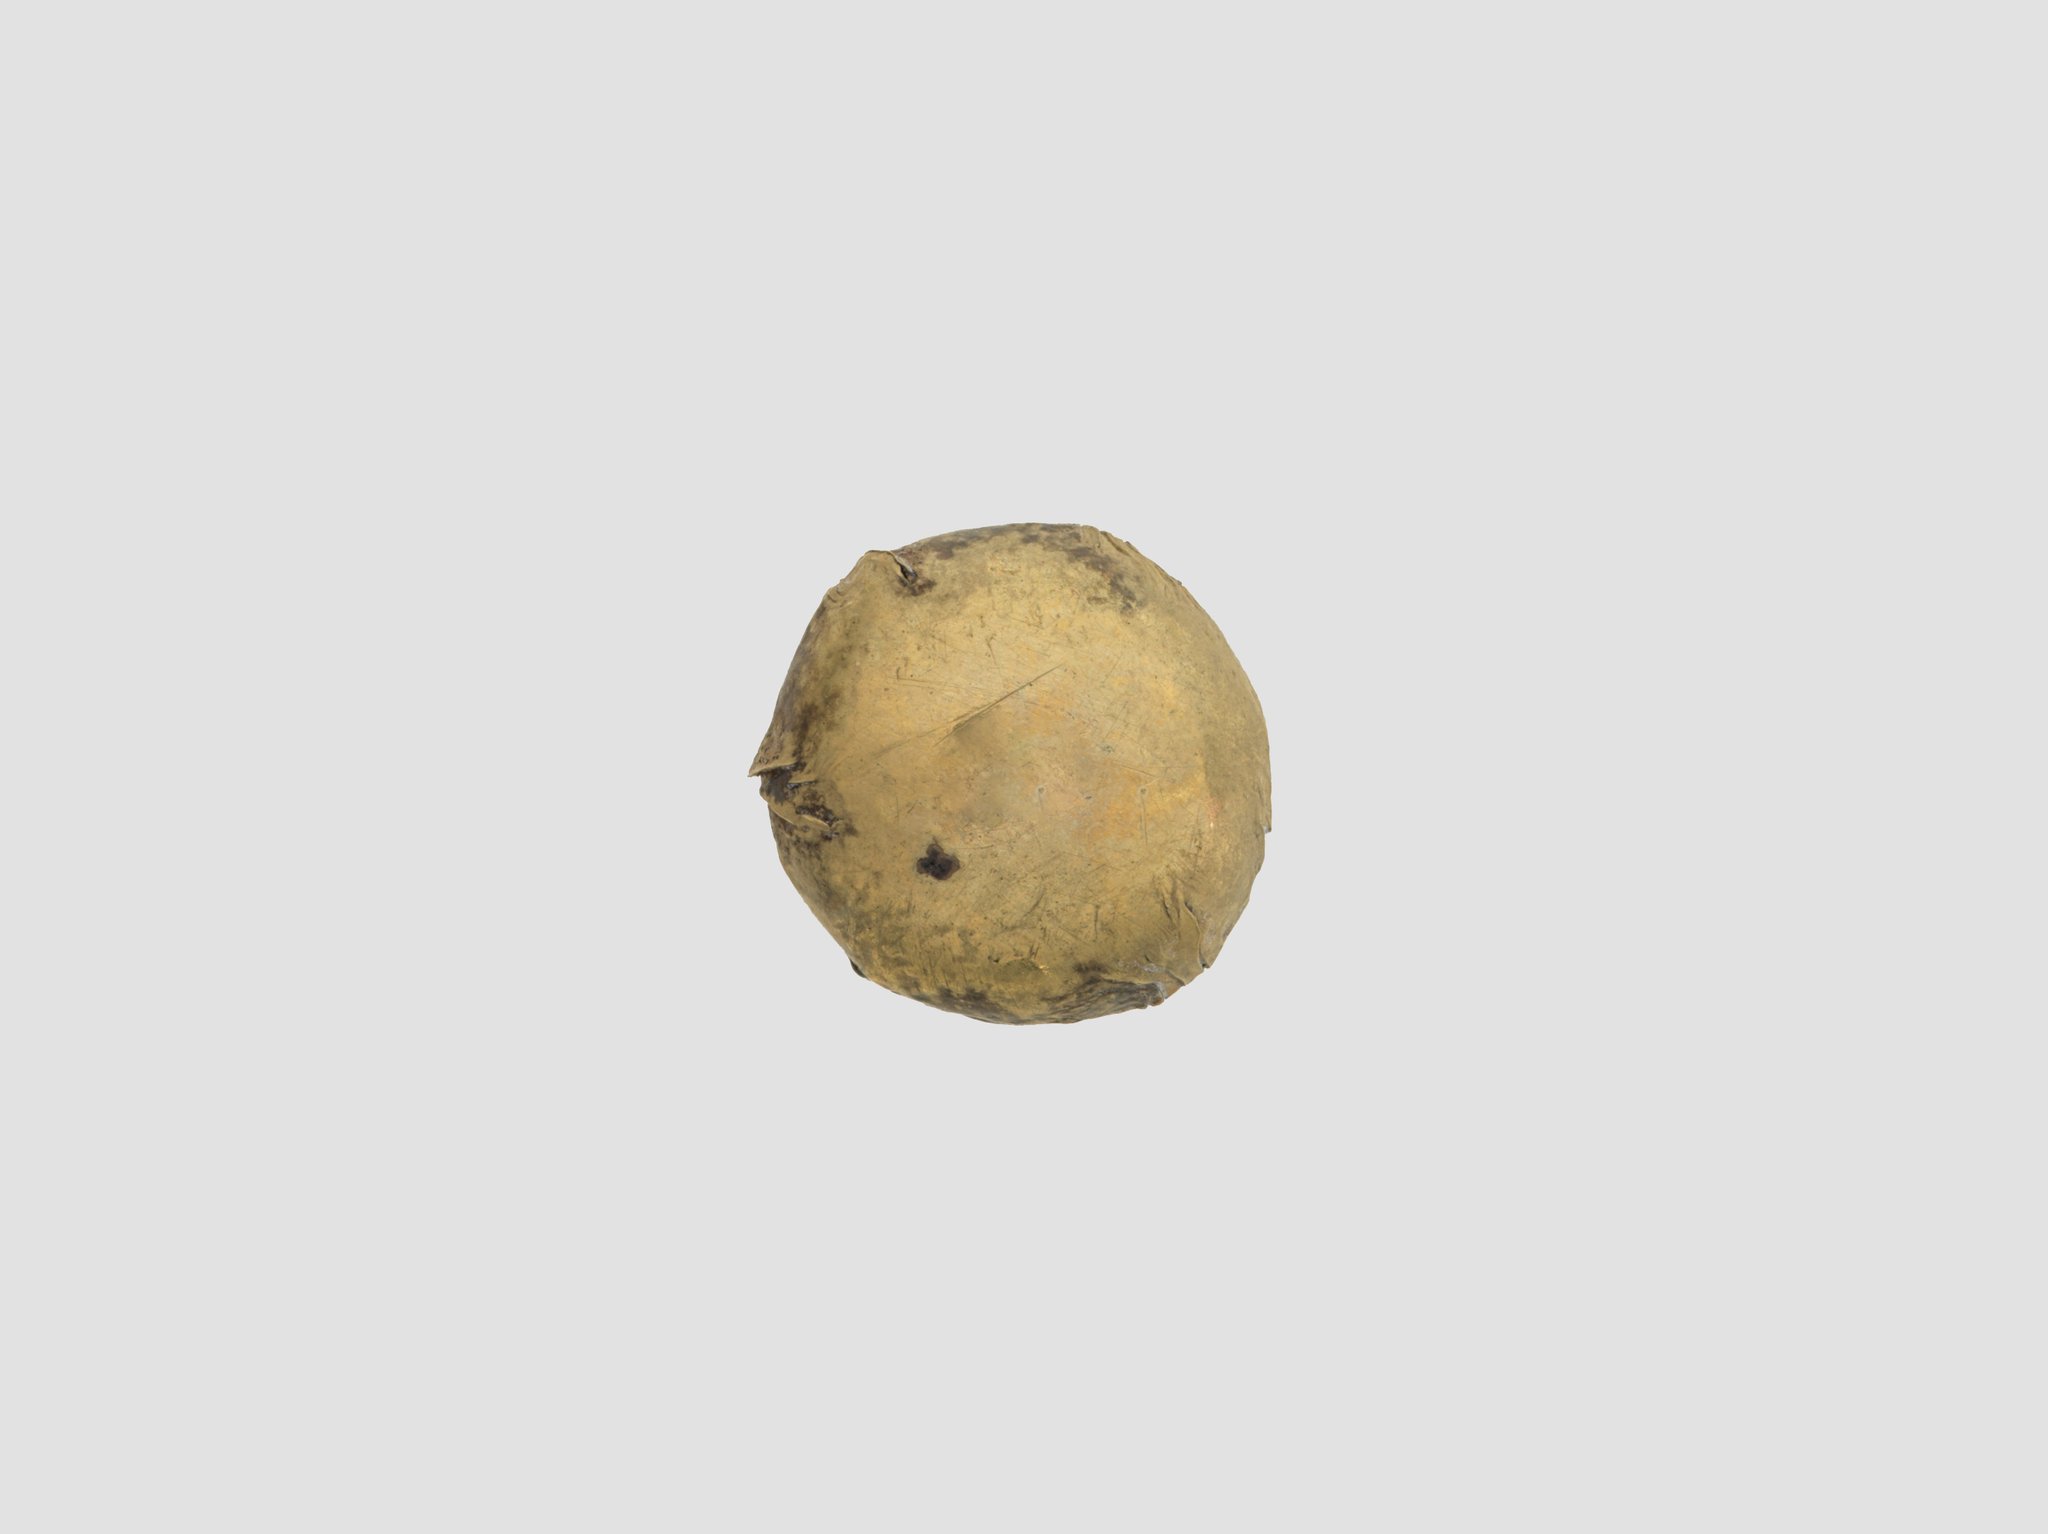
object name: stud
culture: iranian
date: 900-801 BCE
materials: bronze, copper, gold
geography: iran